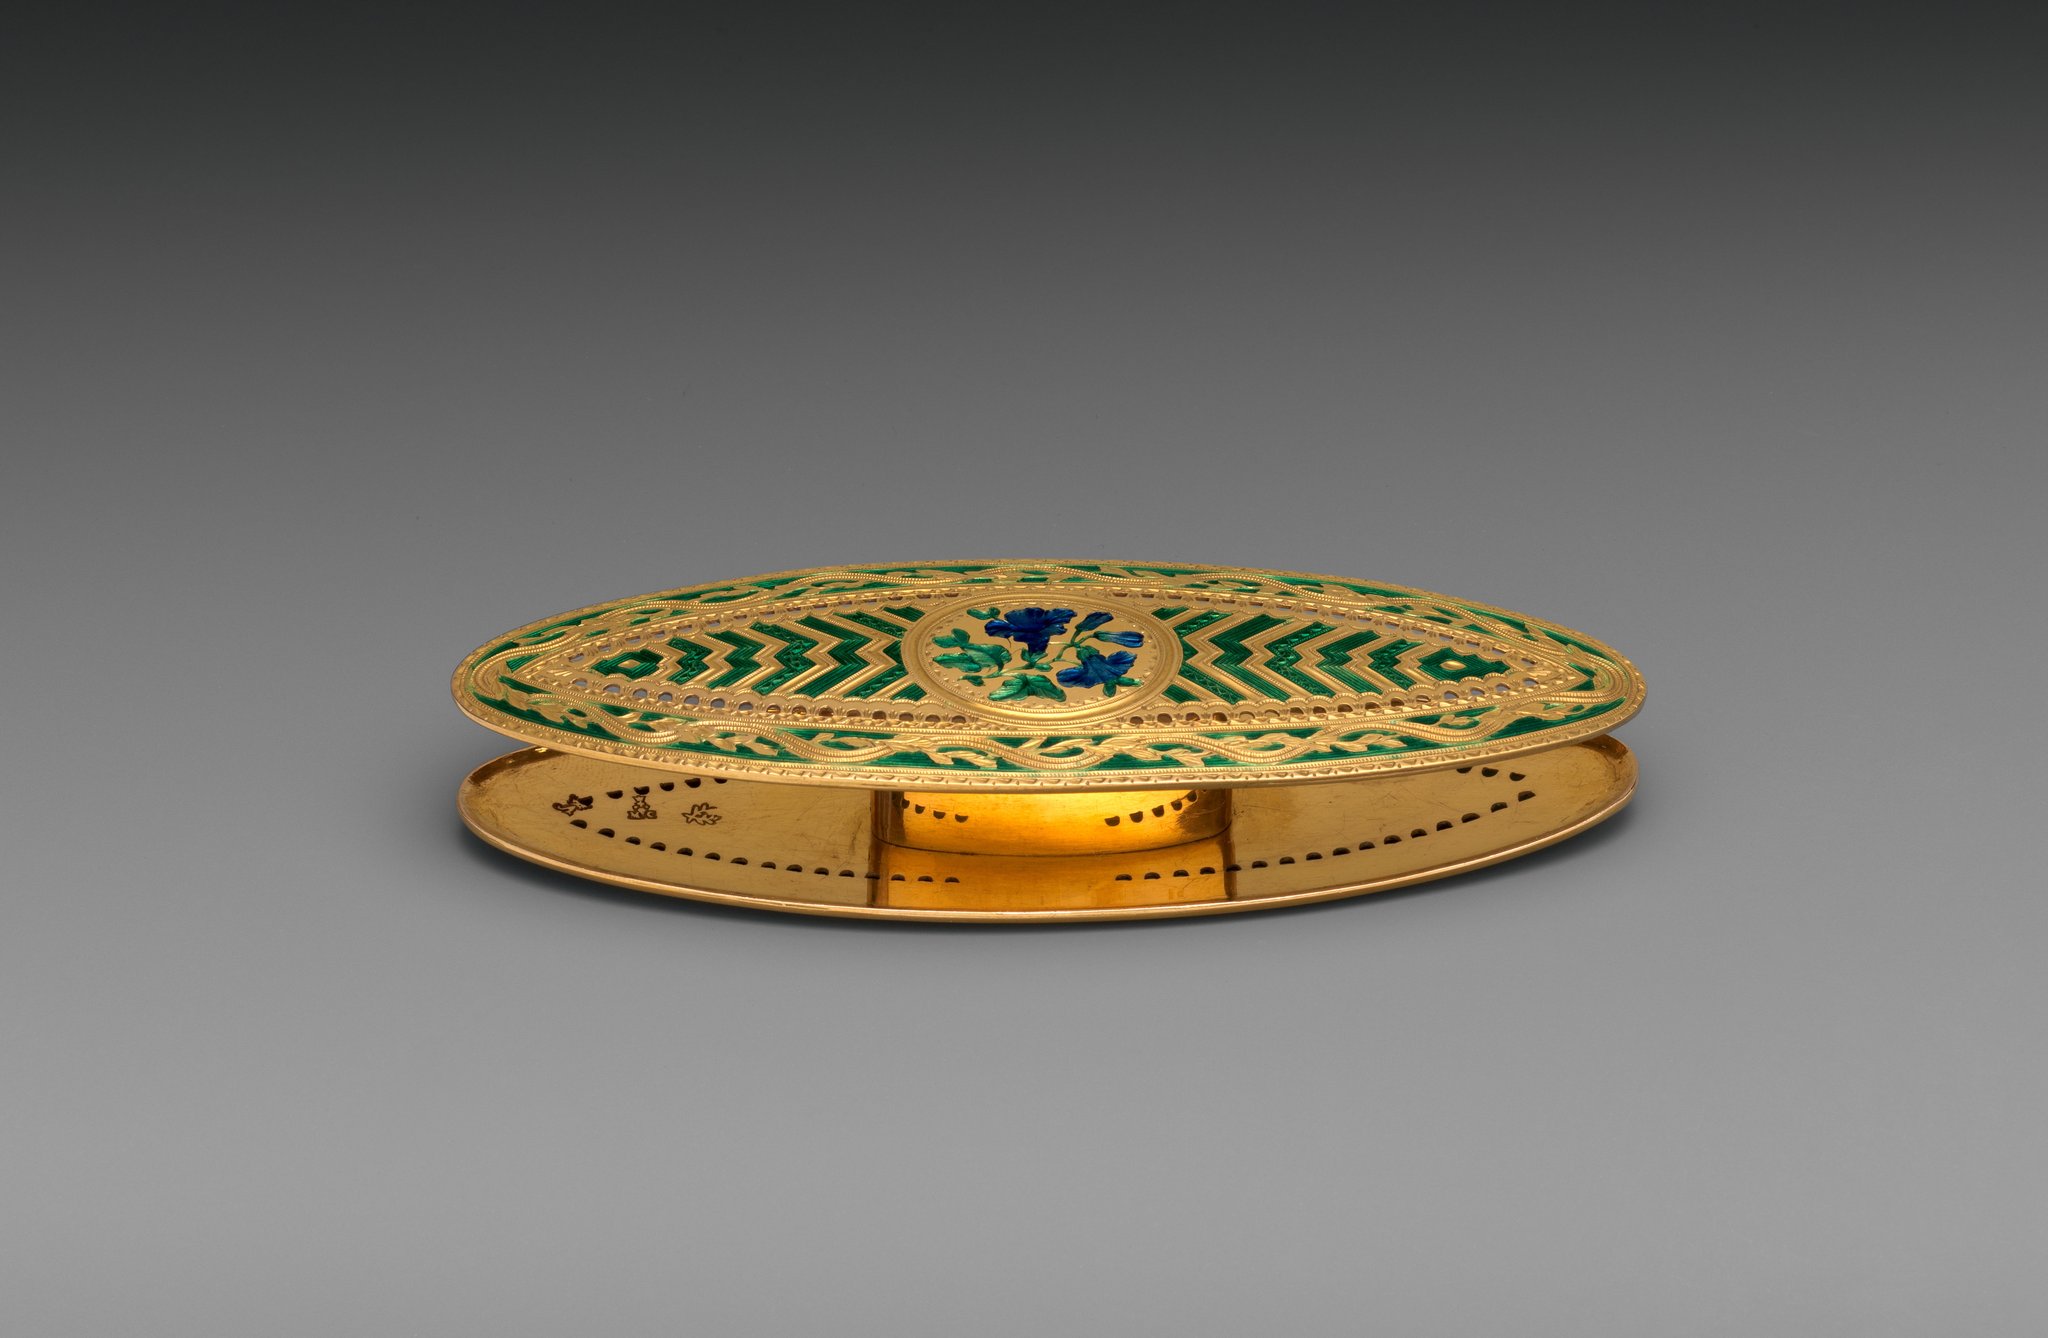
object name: shuttle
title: Shuttle (navette)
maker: mathieu coiny fils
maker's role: maker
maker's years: 1723-1823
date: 1764-1765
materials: enamel, gold